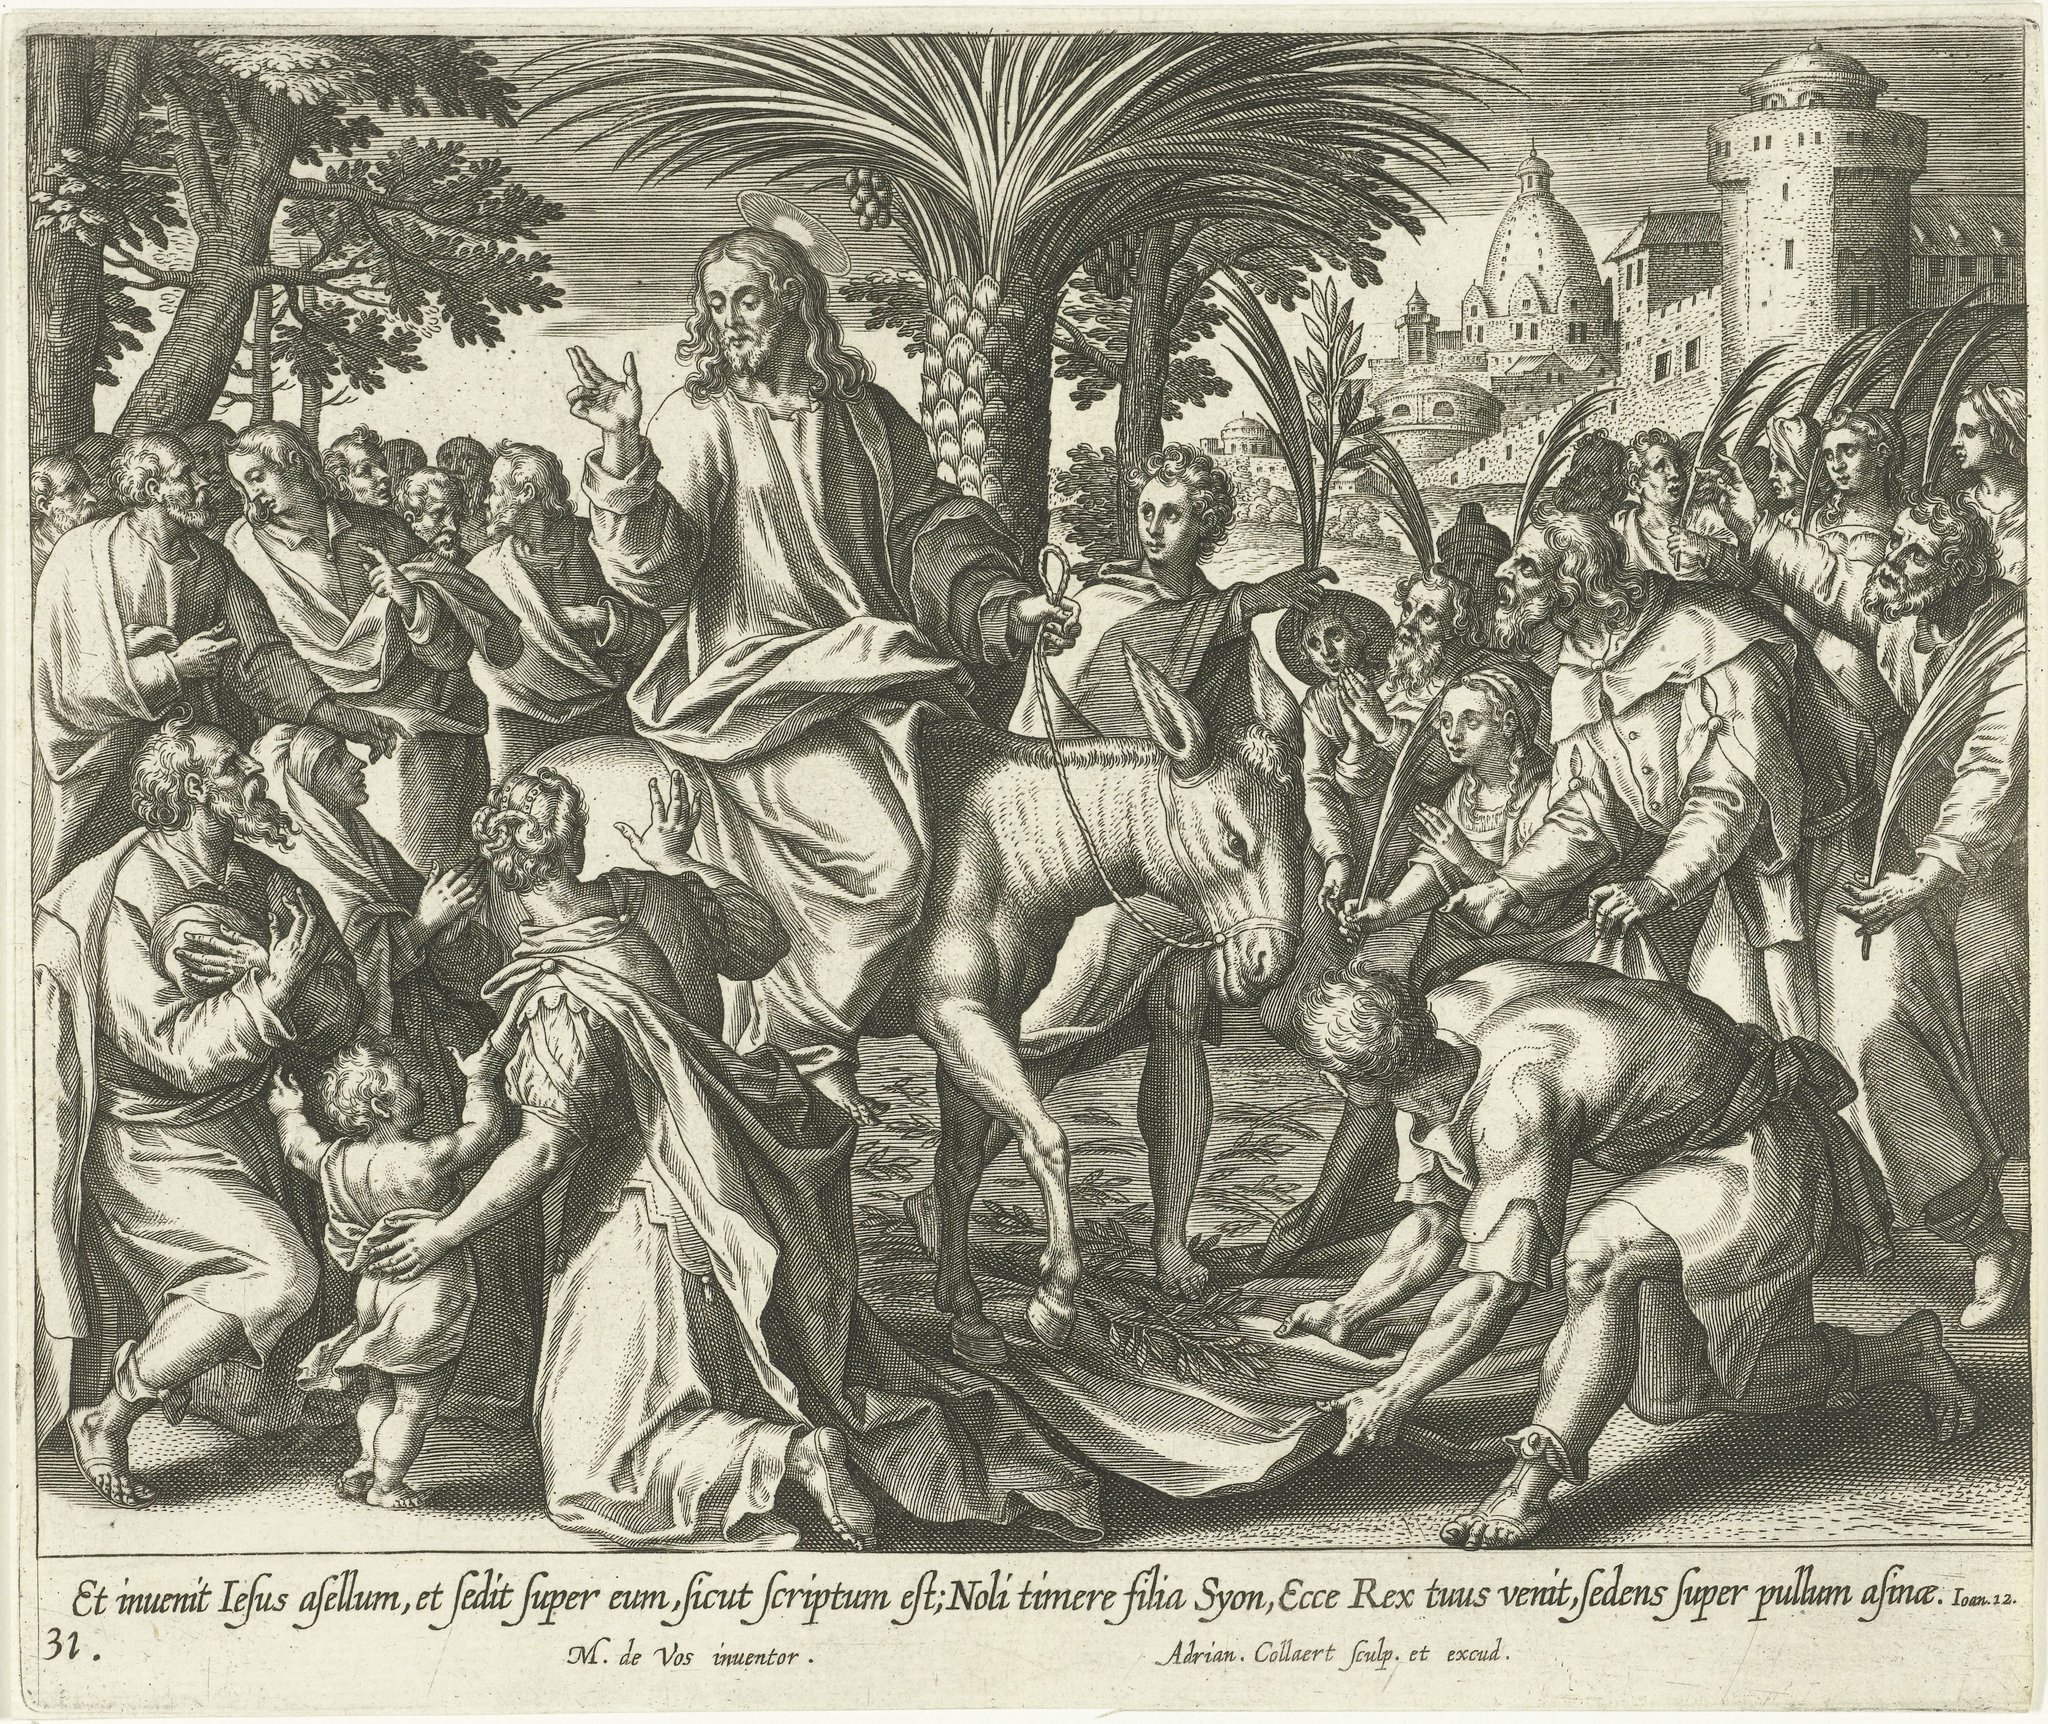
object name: print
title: Intocht in Jeruzalem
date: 1598-1618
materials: paper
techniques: engraving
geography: antwerp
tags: entry into jerusalem: people spreading their clothes before christ on the ass, and waving palm branches (matthew 21:1-11, 21:14-16; mark 11:1-11; luke 19:28-40; john 12:12-19)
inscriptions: collector's mark: Lugt 2228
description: Christus, gezeten op een ezel, rijdt binnen in Jeruzalem. Rondom hem zwaaien mensen met palmtakken. Een man legt zijn mantel voor Christus neer op de grond (Johannes 12:12-15). De prent heeft een Latijns onderschrift. De prent maakt deel uit van een serie over het leven van Christus.